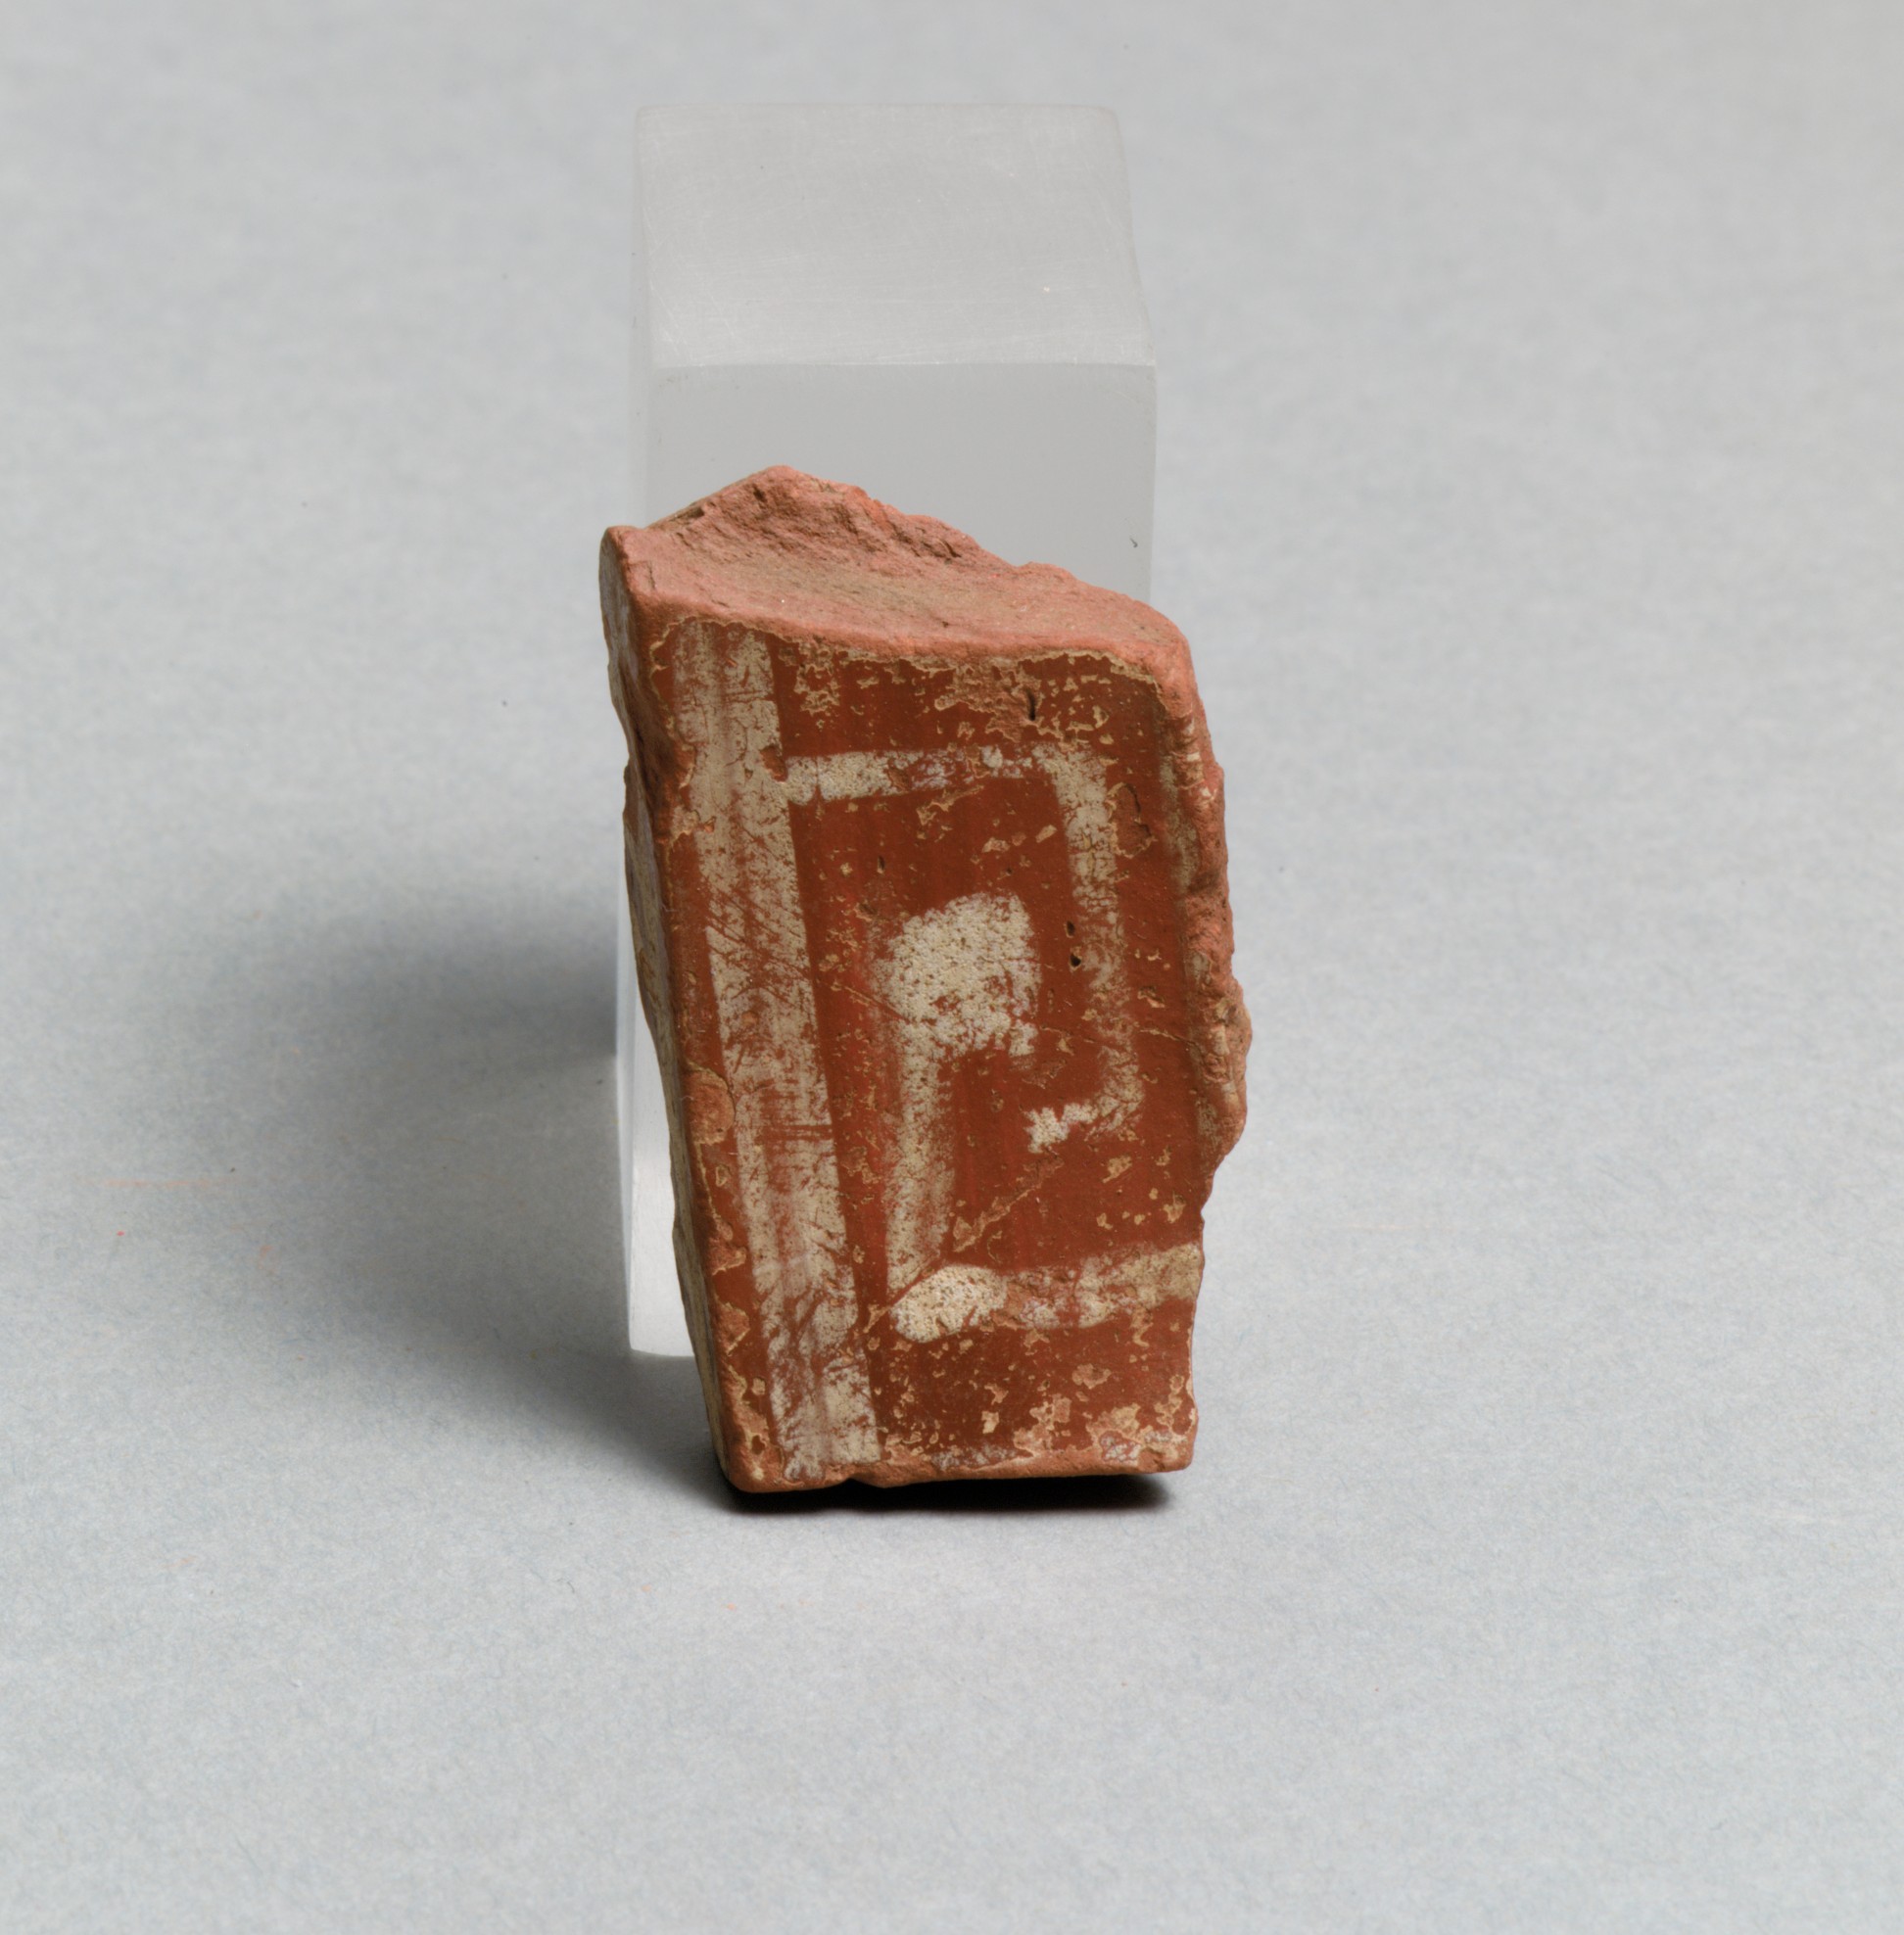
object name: vase fragment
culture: greek or lydian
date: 900-30 BCE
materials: terracotta